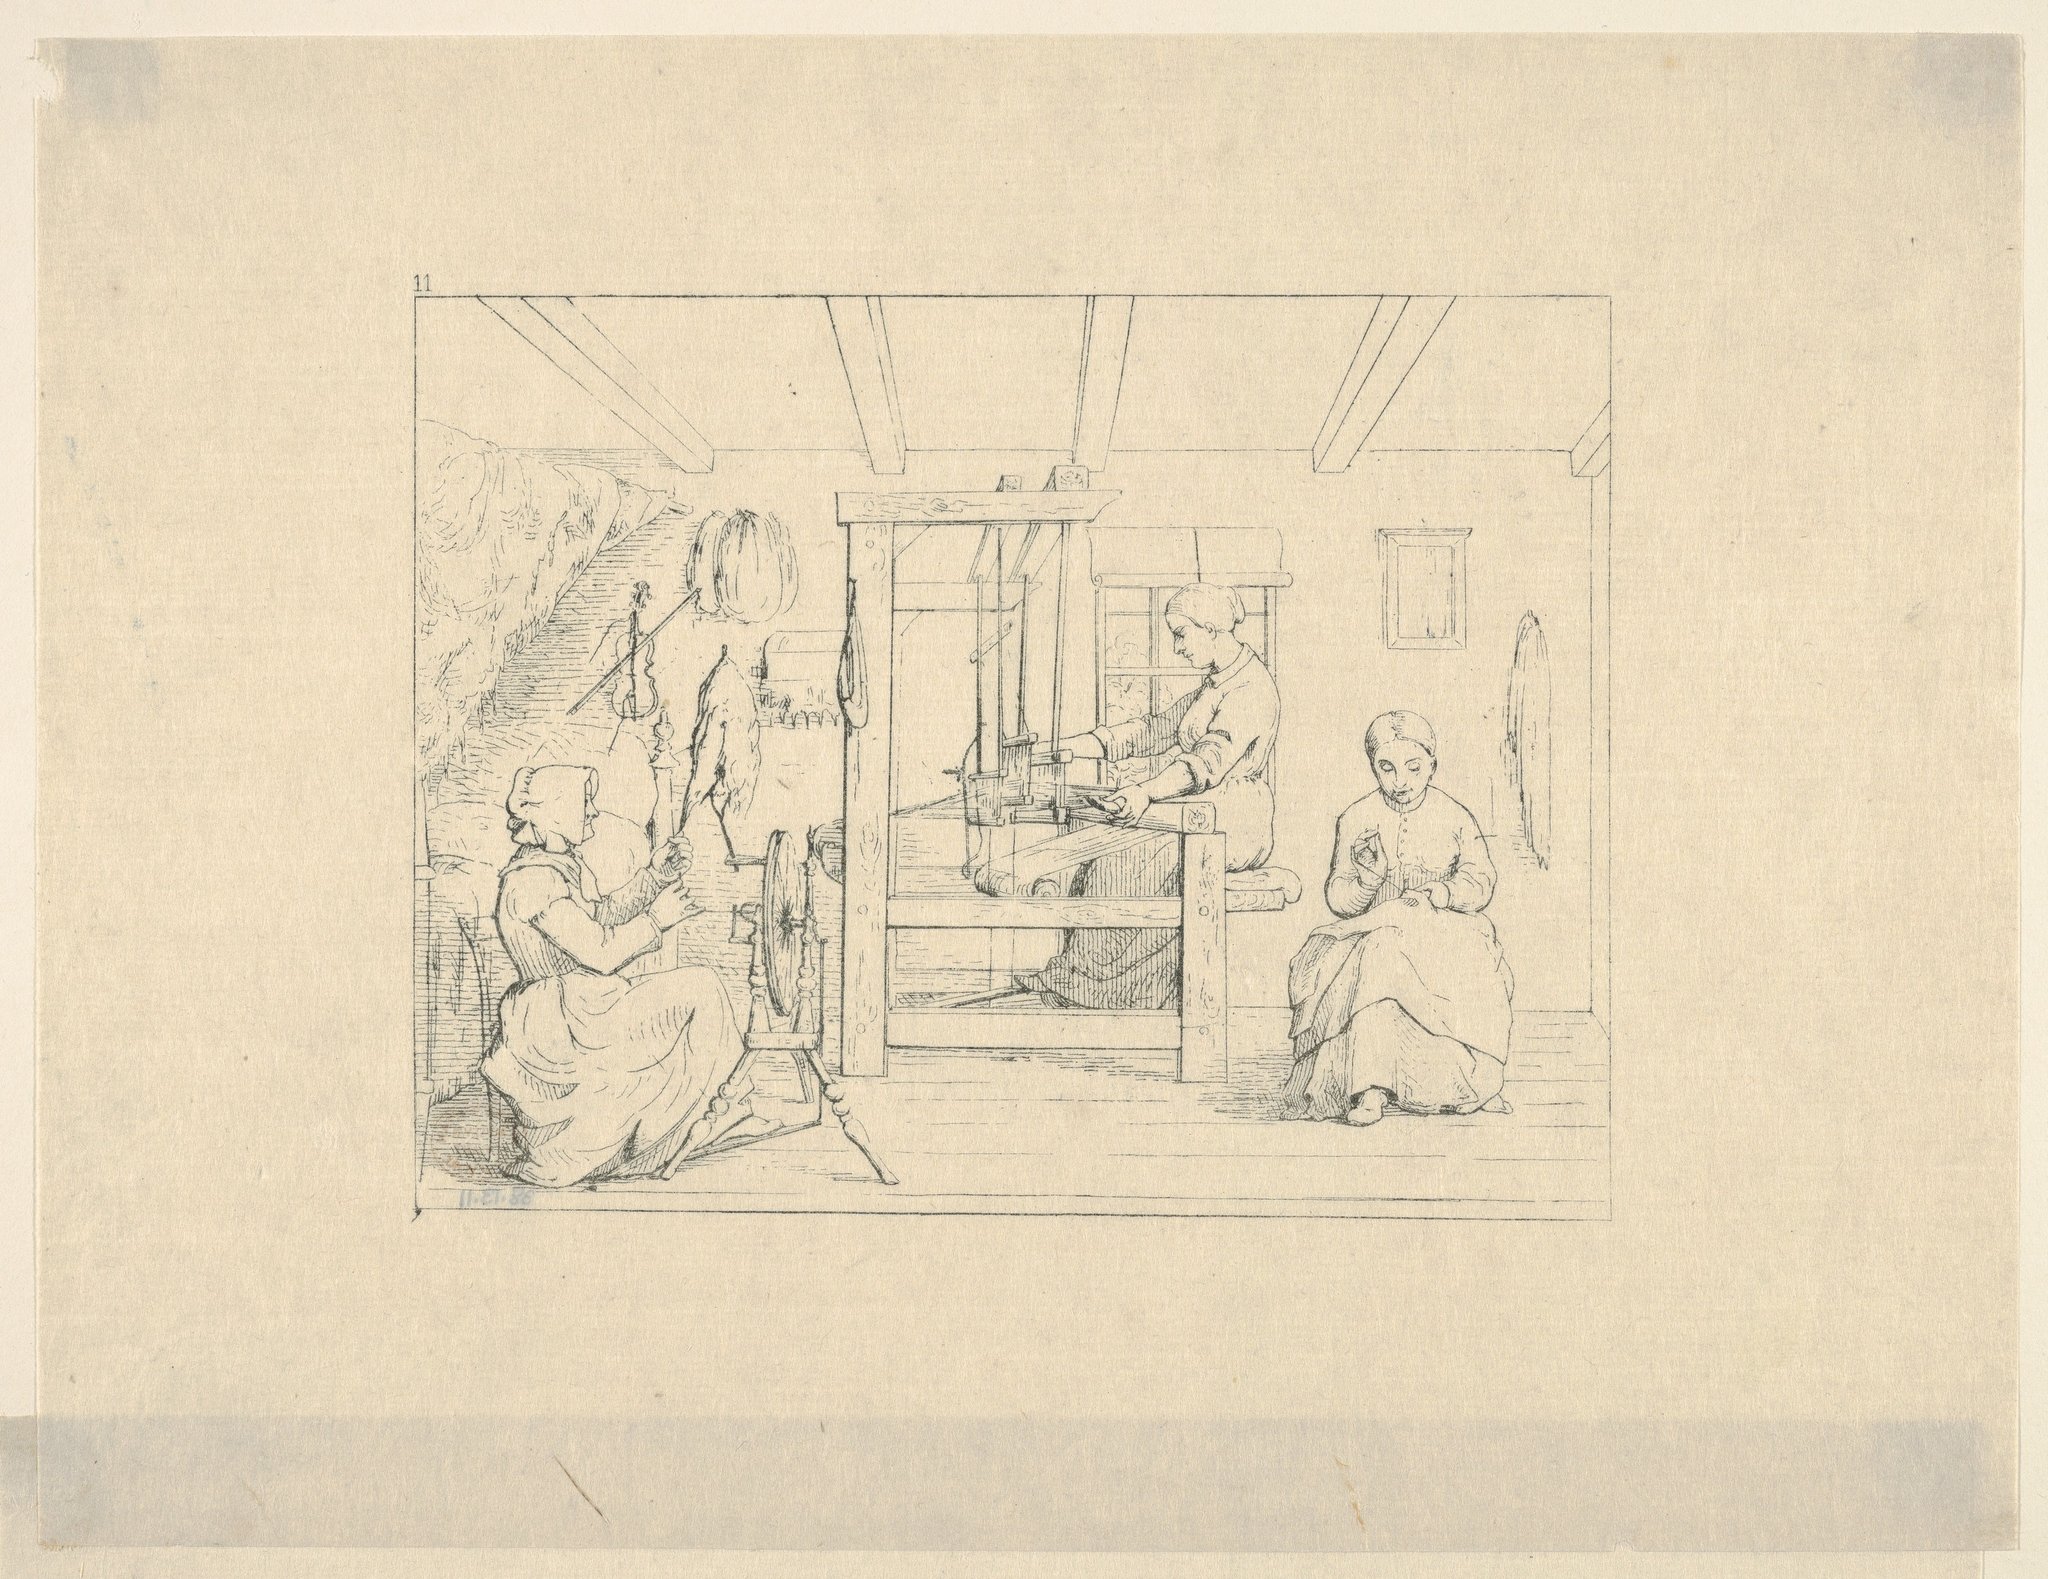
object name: print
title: Making Clothes for the Boys in the Army (from Confederate War Etchings)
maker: adalbert john volck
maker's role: artist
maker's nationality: american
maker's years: 1828-1912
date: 1861-1863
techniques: etching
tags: american civil war,women,working,sewing,looms,spinning wheel